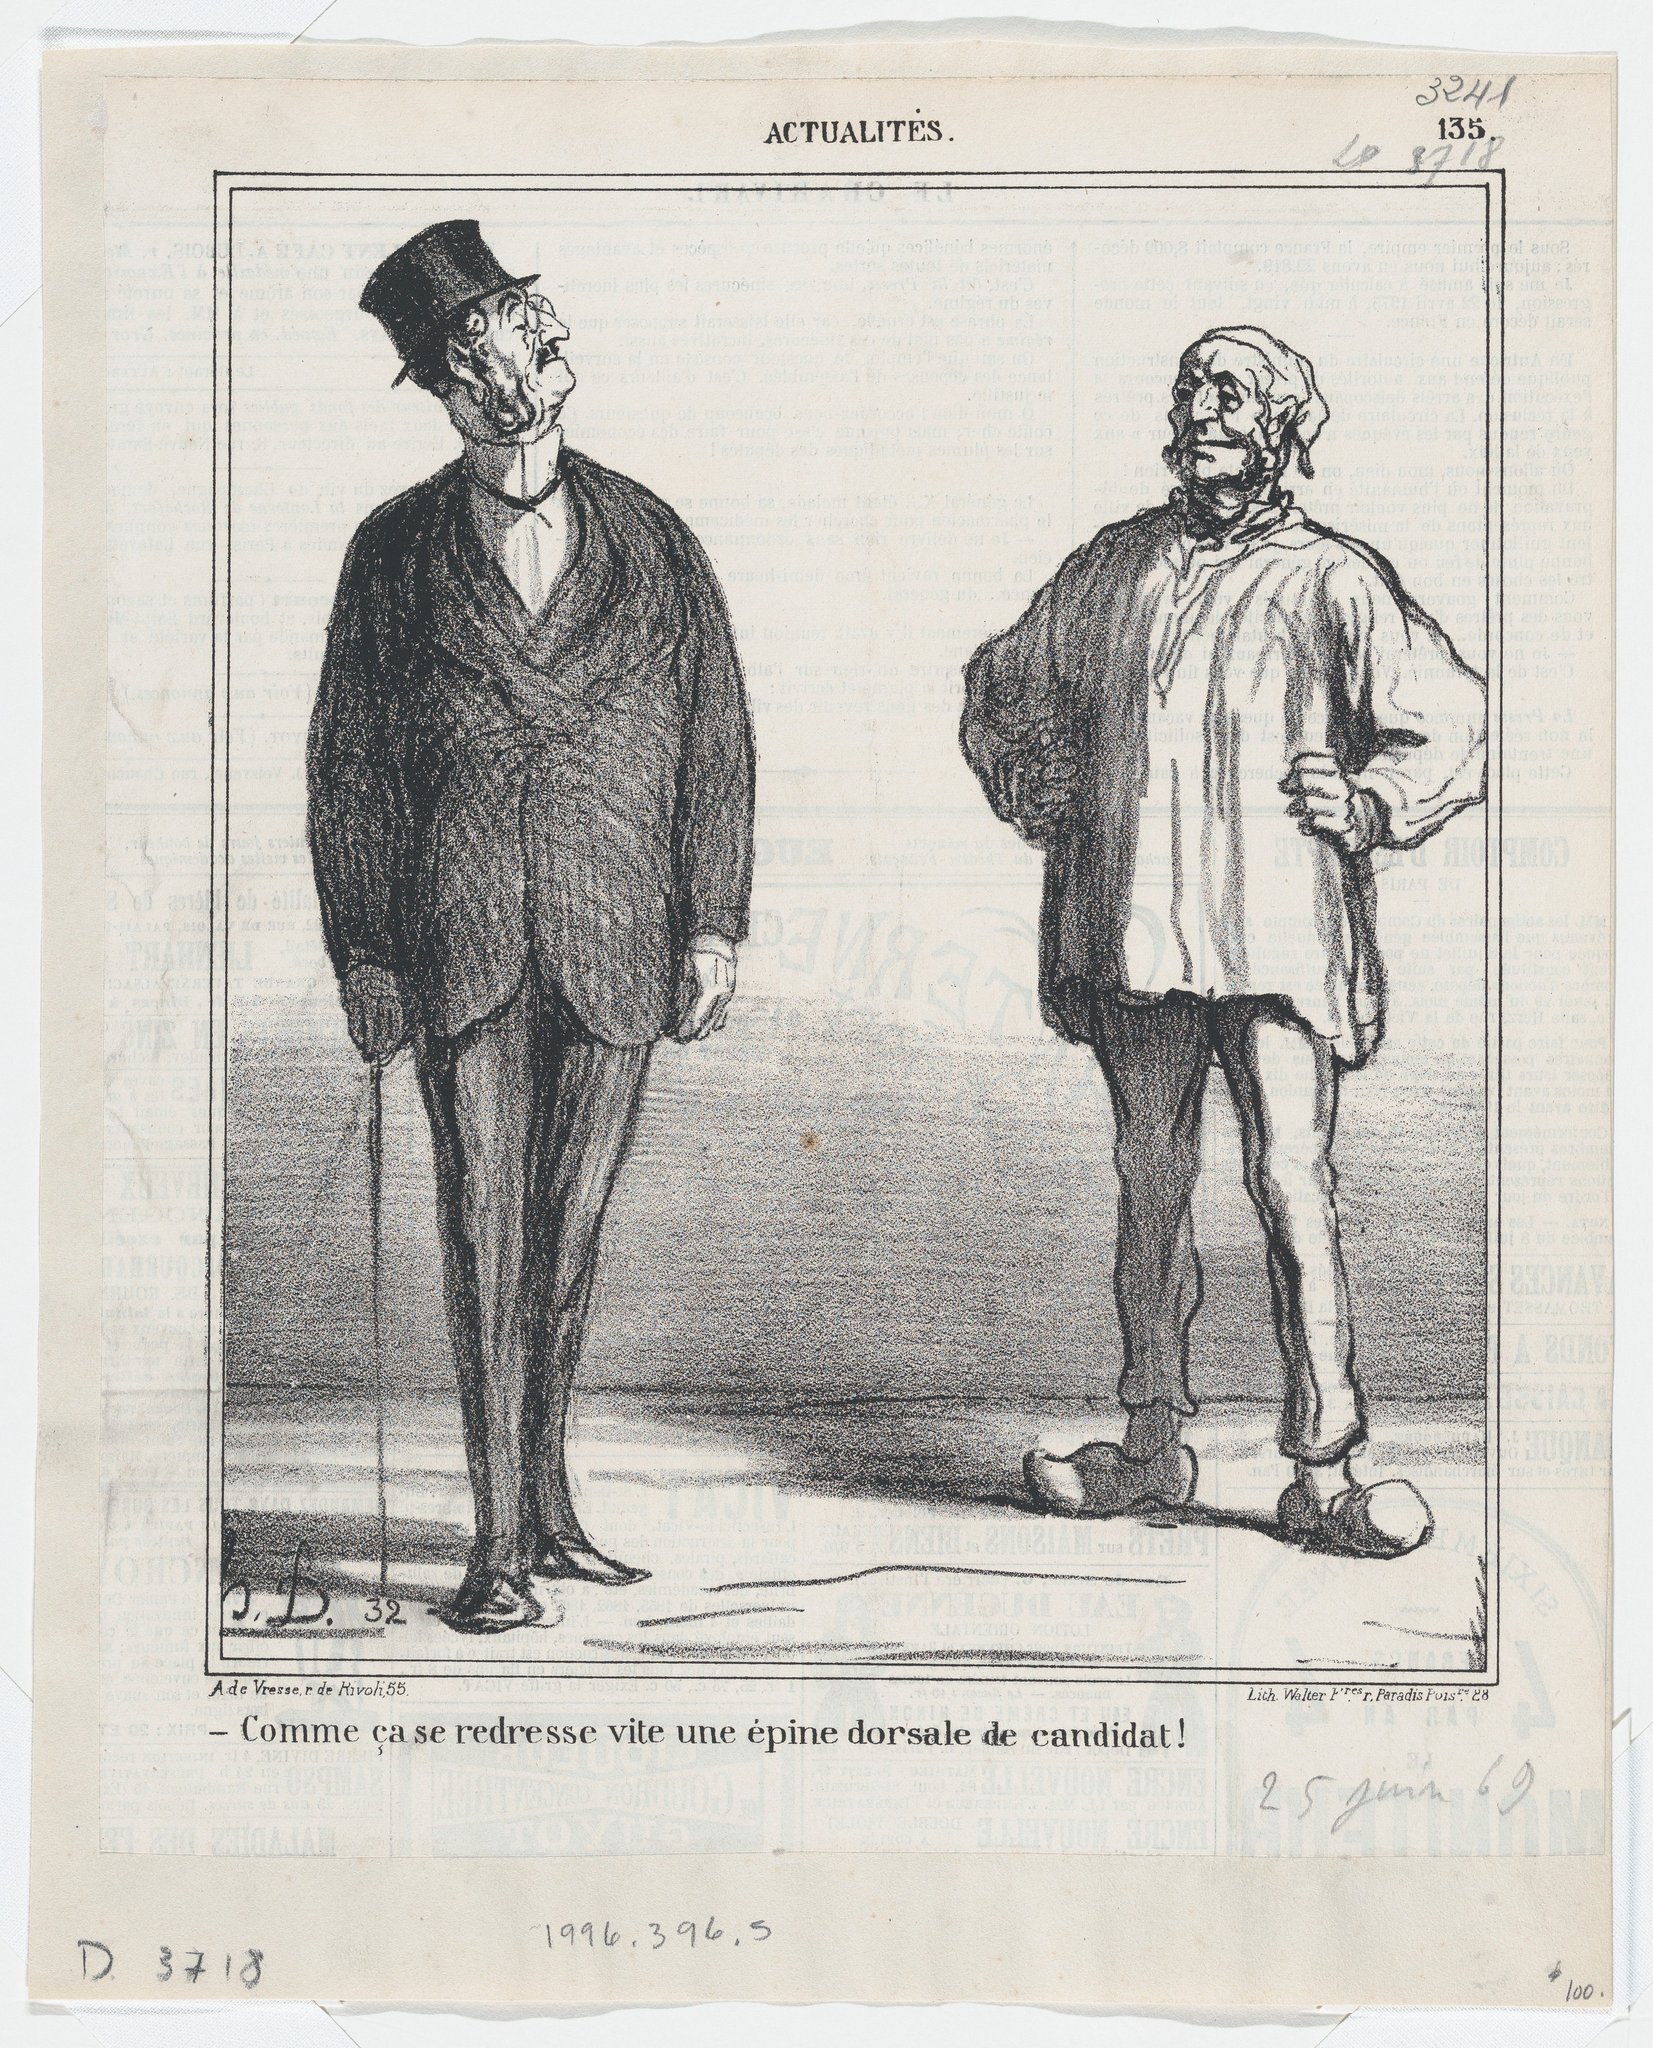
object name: print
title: Comme ça se redresse vite. . .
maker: honoré daumier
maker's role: artist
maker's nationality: french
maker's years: 1808-1879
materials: paper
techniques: lithograph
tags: men